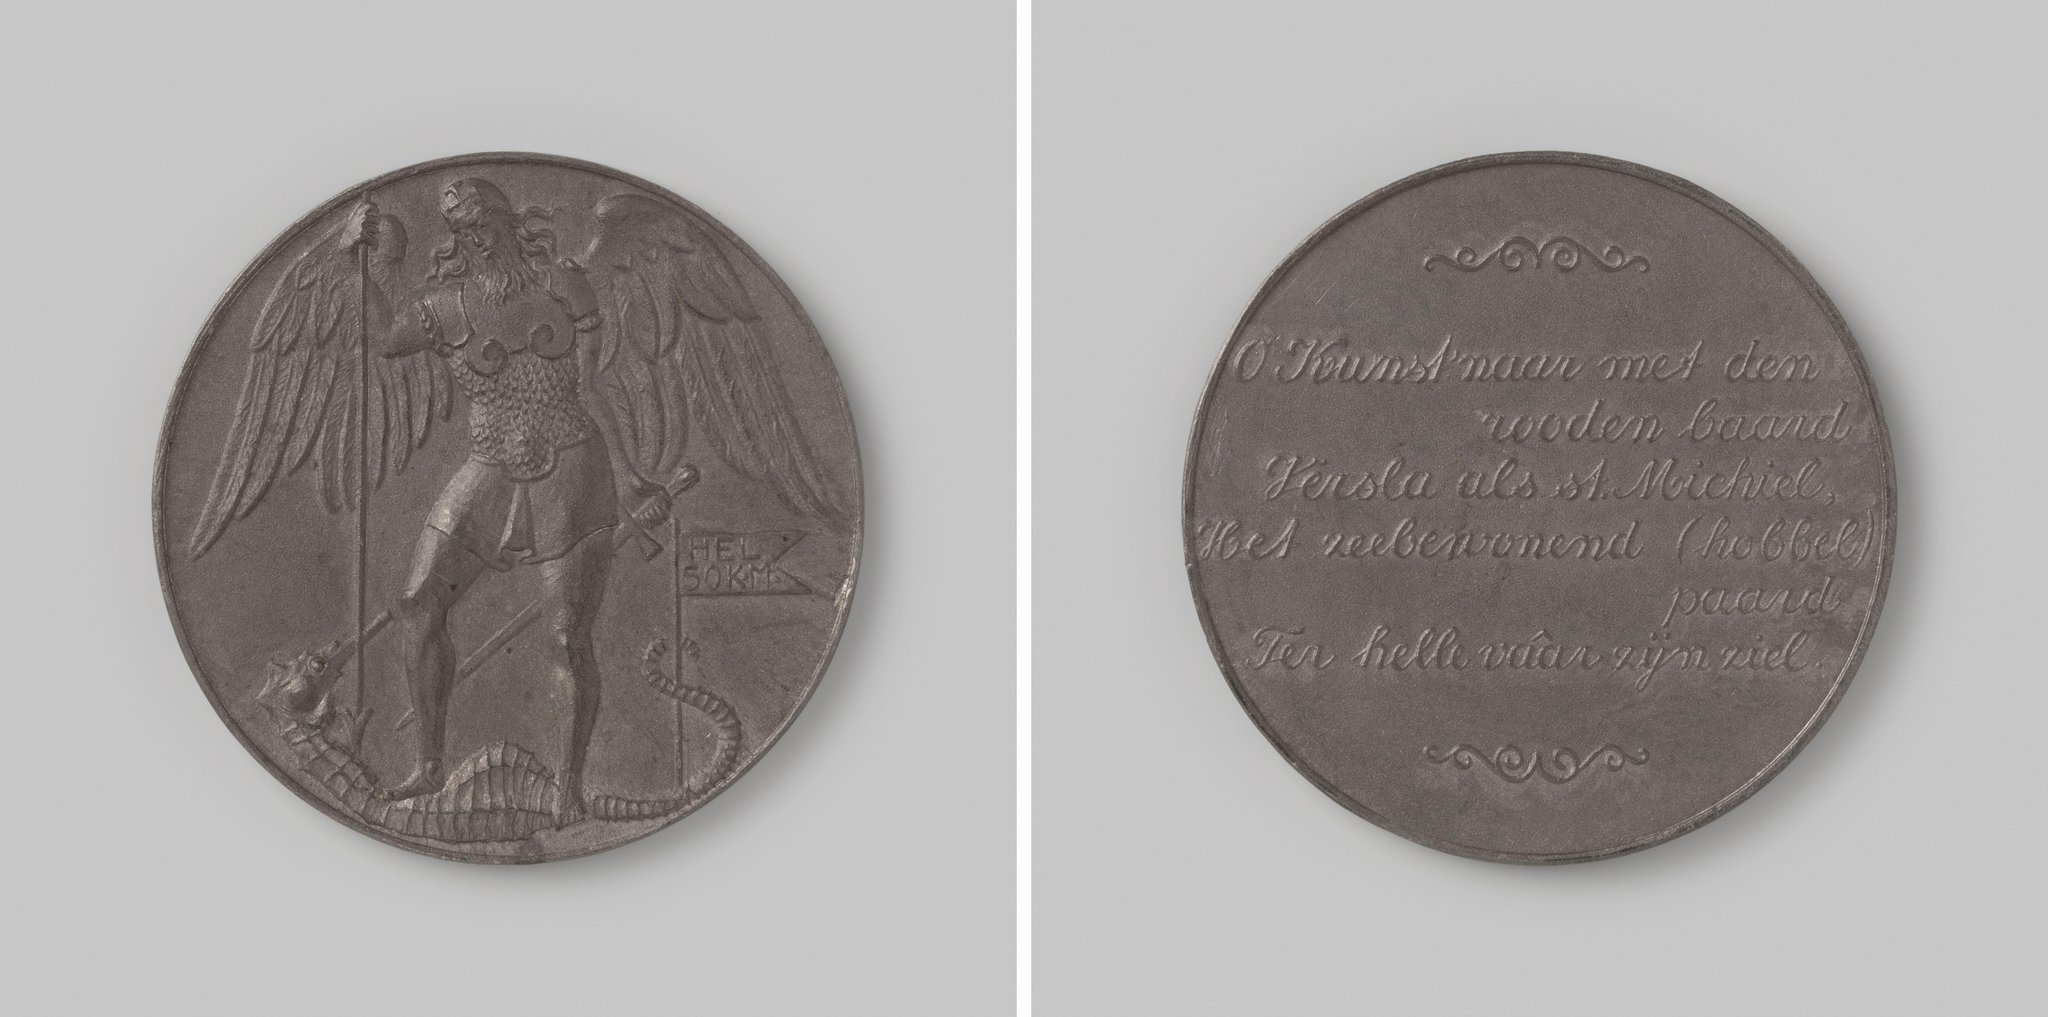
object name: history medal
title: Spotpenning op de onmin tussen 's Rijks stempelsnijder Wienecke en muntmeester Hoitsema 1921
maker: johannes cornelis wienecke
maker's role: medailleur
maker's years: 1872-1945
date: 1921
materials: tin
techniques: striking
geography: utrecht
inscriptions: inscription: ‘O Kunst'naar met den / rooden baard / Versla als st. Michiel, / Het zeebewonend (hobbel) / paard / Ter helle vaâr zijn ziel.’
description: Tinnen penning, op de voorzijde Wienecke, als gebaarde Sint Michiel, die een zeepaardje verslaat met diens staart rond een vaantje "HEL / 50 K.M.", op de keerzijde zes regels tekst in schoonschrift.